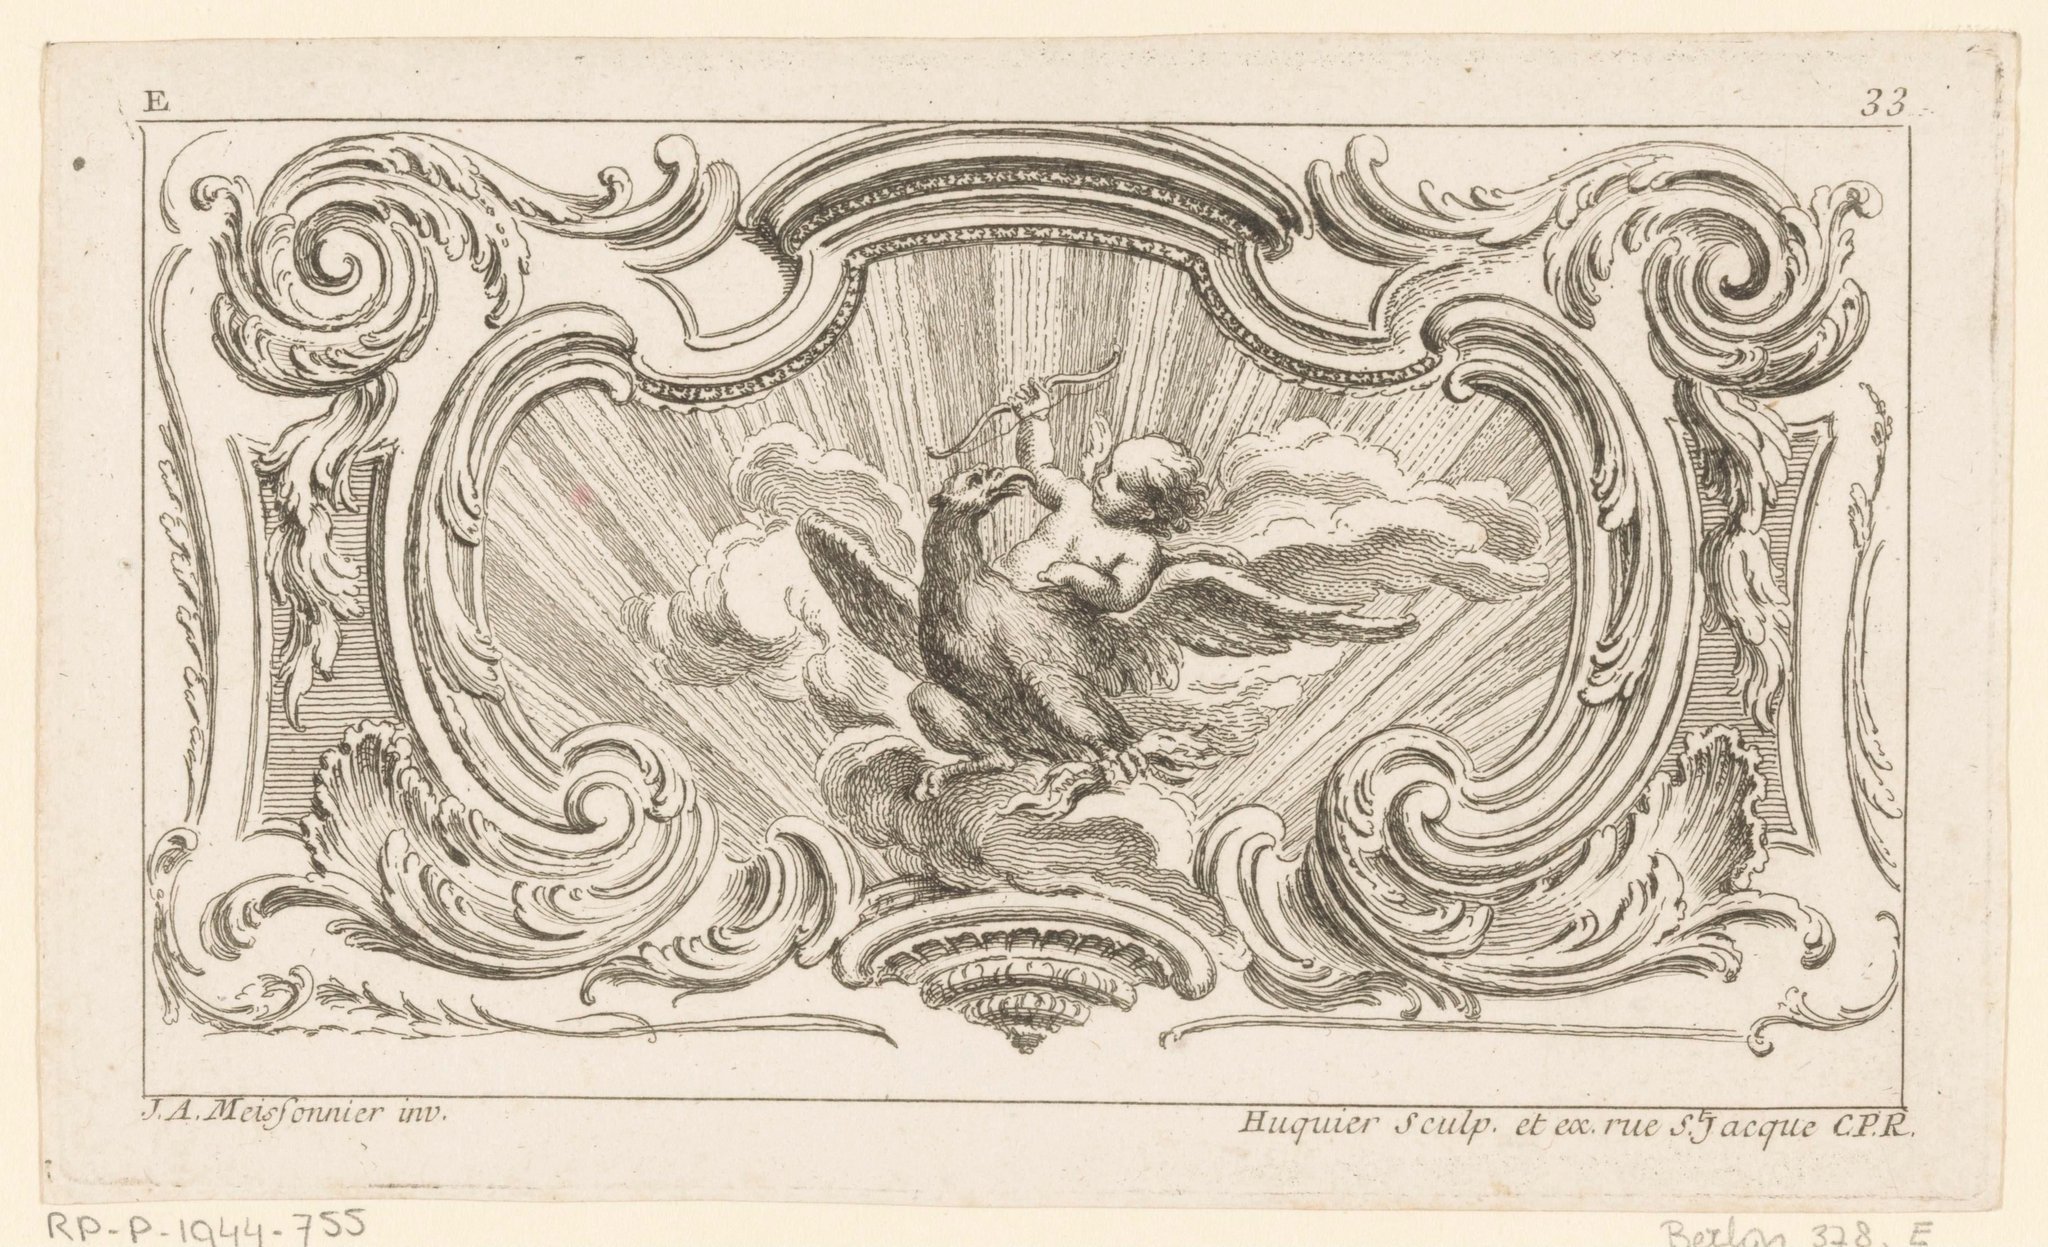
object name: print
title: E Cinquieme Livre D'Ornemens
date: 1738-1749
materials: paper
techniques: etching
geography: paris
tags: predatory birds: eagle, cupids: 'amores', 'amoretti', 'putti'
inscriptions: collector's mark: Lugt 2228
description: Een putto met een boog zit op de rug van een adelaar. Rondom de voorstelling een rocaille omlijsting. Prentnummer 33.